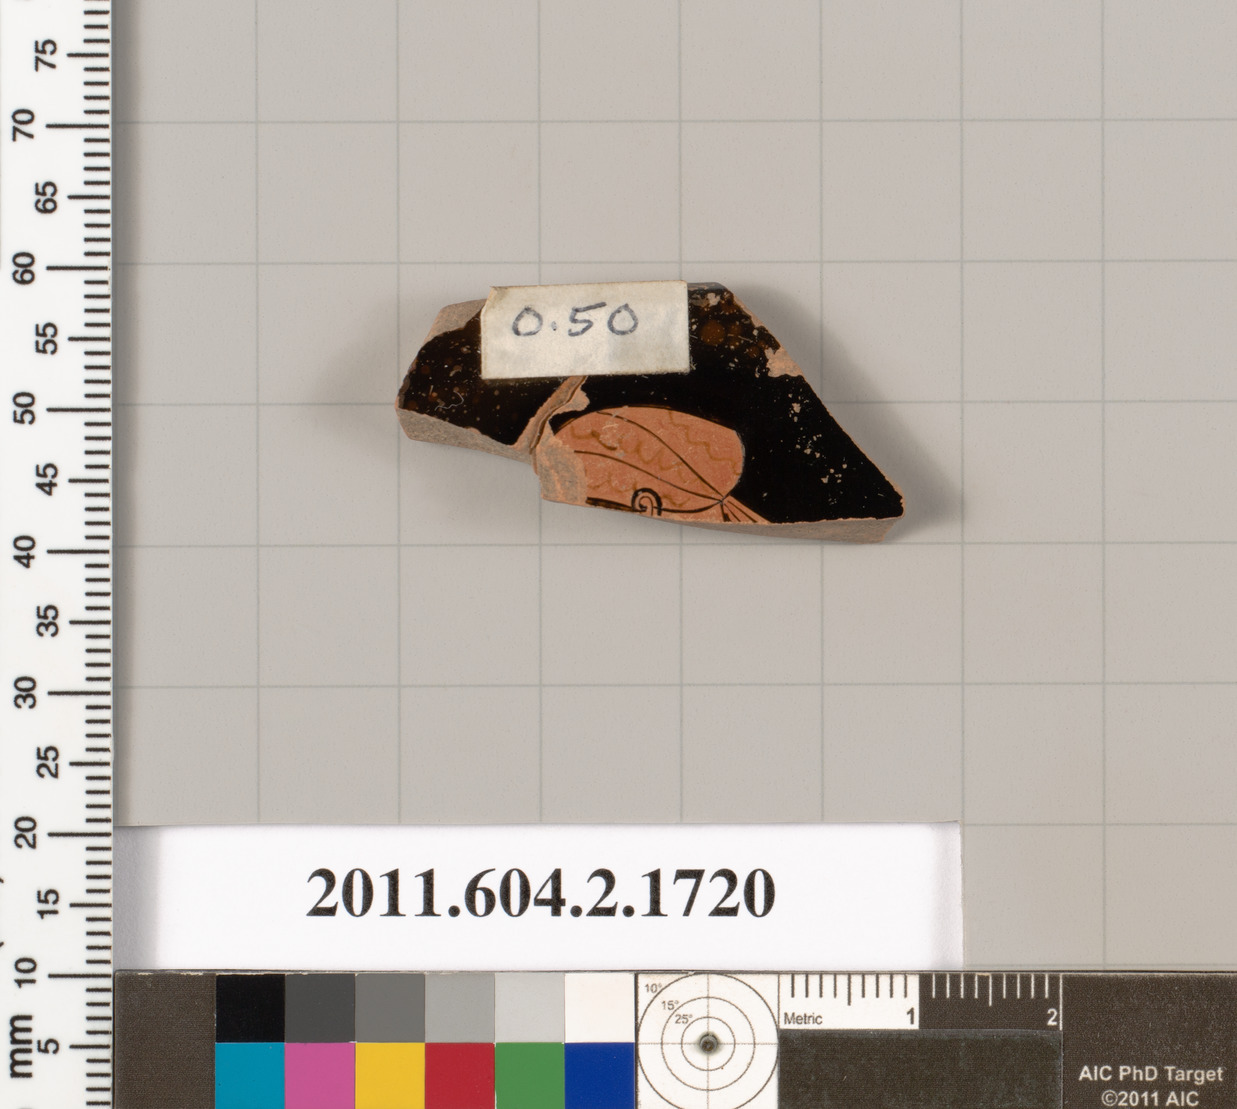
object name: skyphos fragment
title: Terracotta rim fragment of a skyphos (deep drinking cup)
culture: greek, attic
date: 490-470 BCE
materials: terracotta